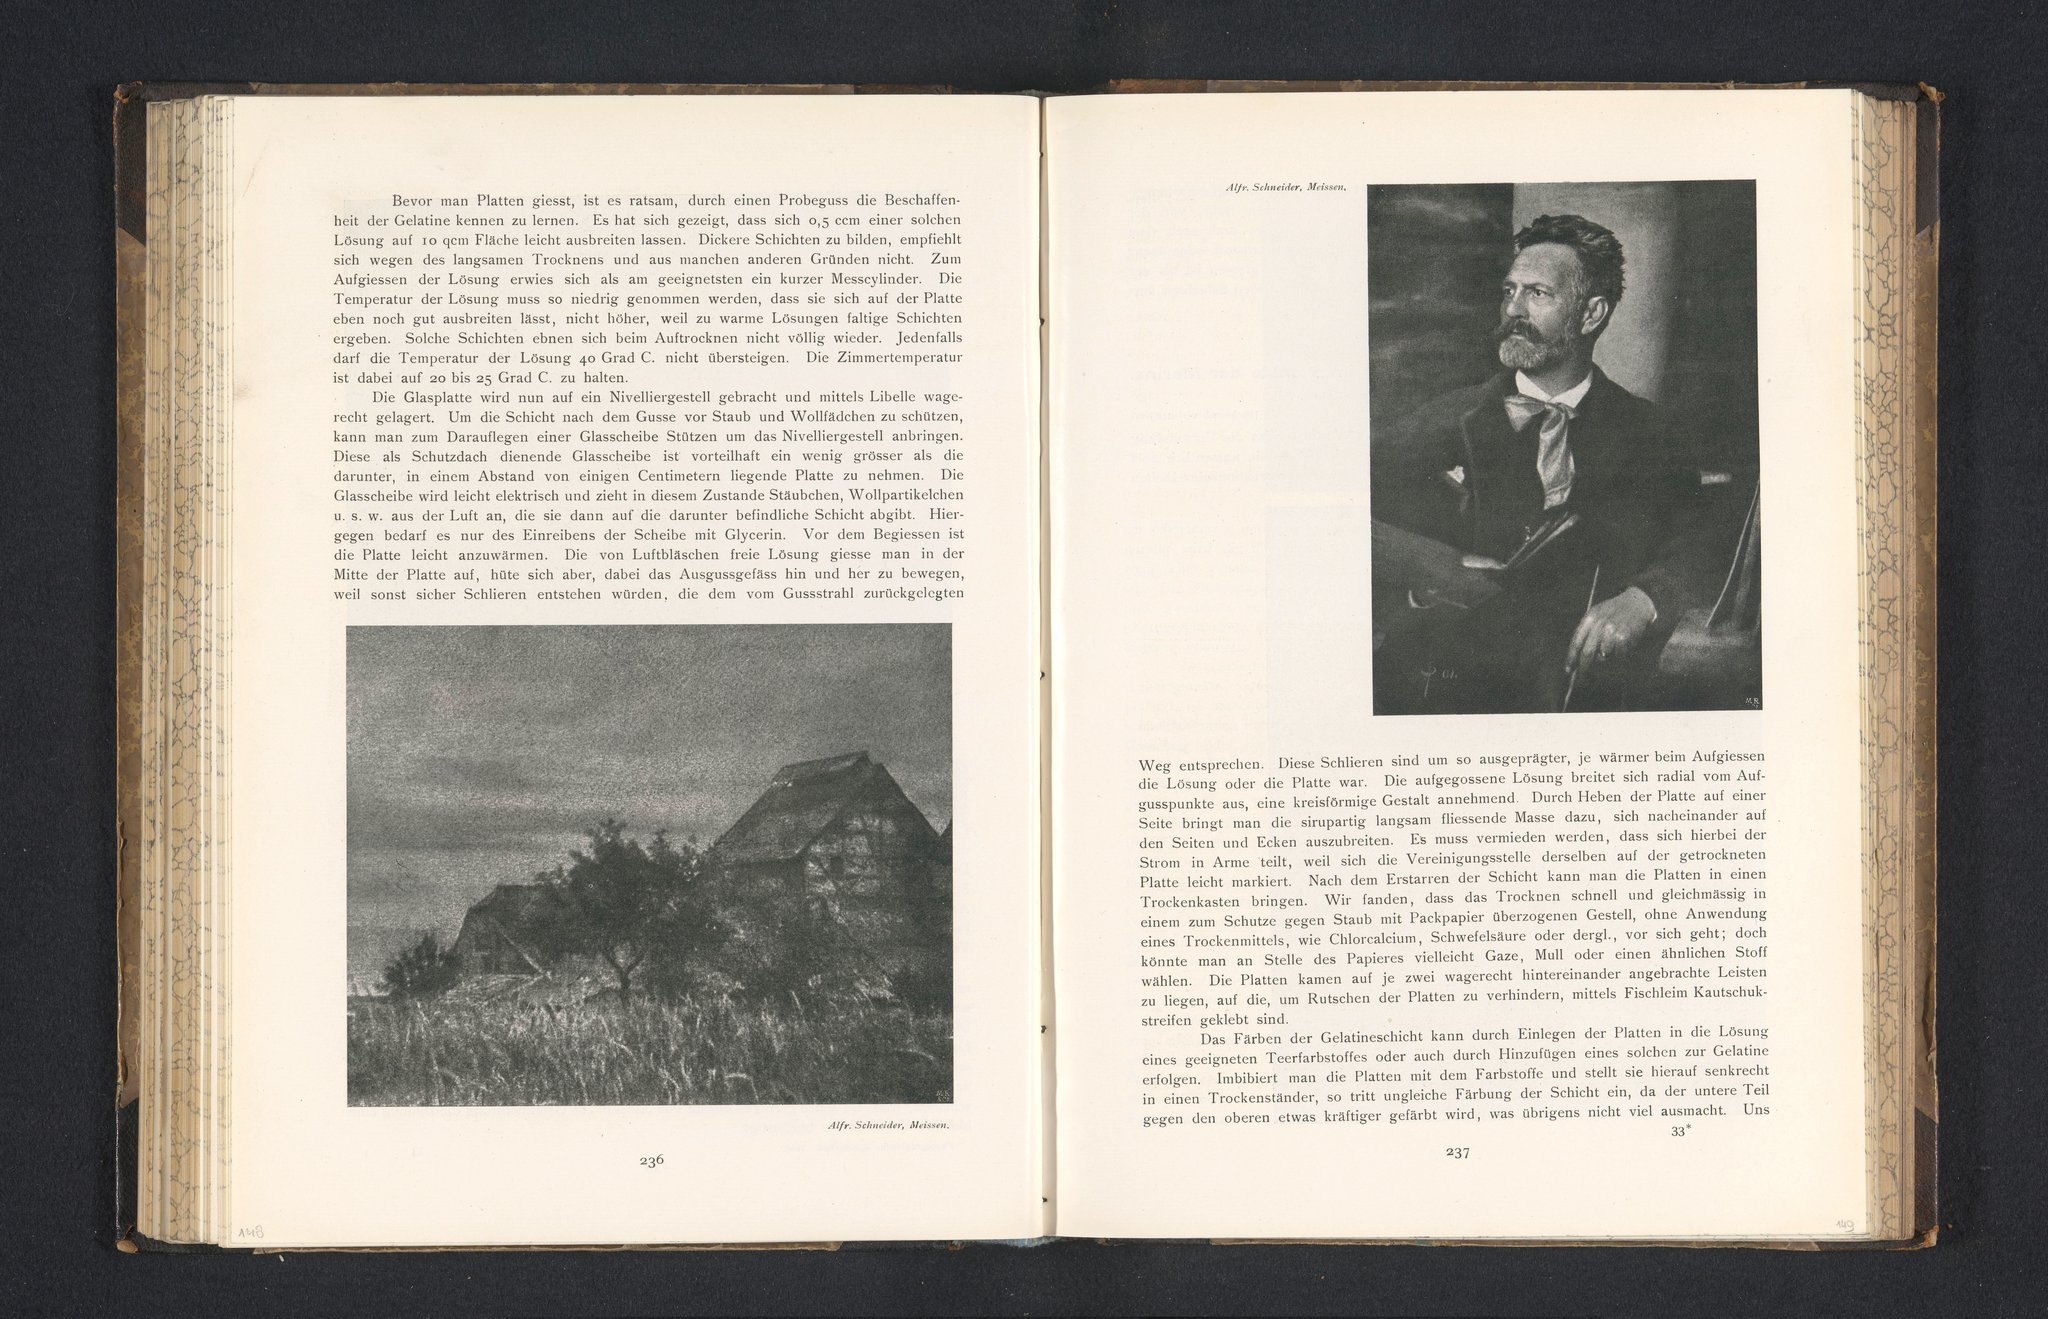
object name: page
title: Portret van een onbekende man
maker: alfred schneider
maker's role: fotograaf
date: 1901-1903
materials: paper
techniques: autotype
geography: berlin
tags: historical persons not known by name